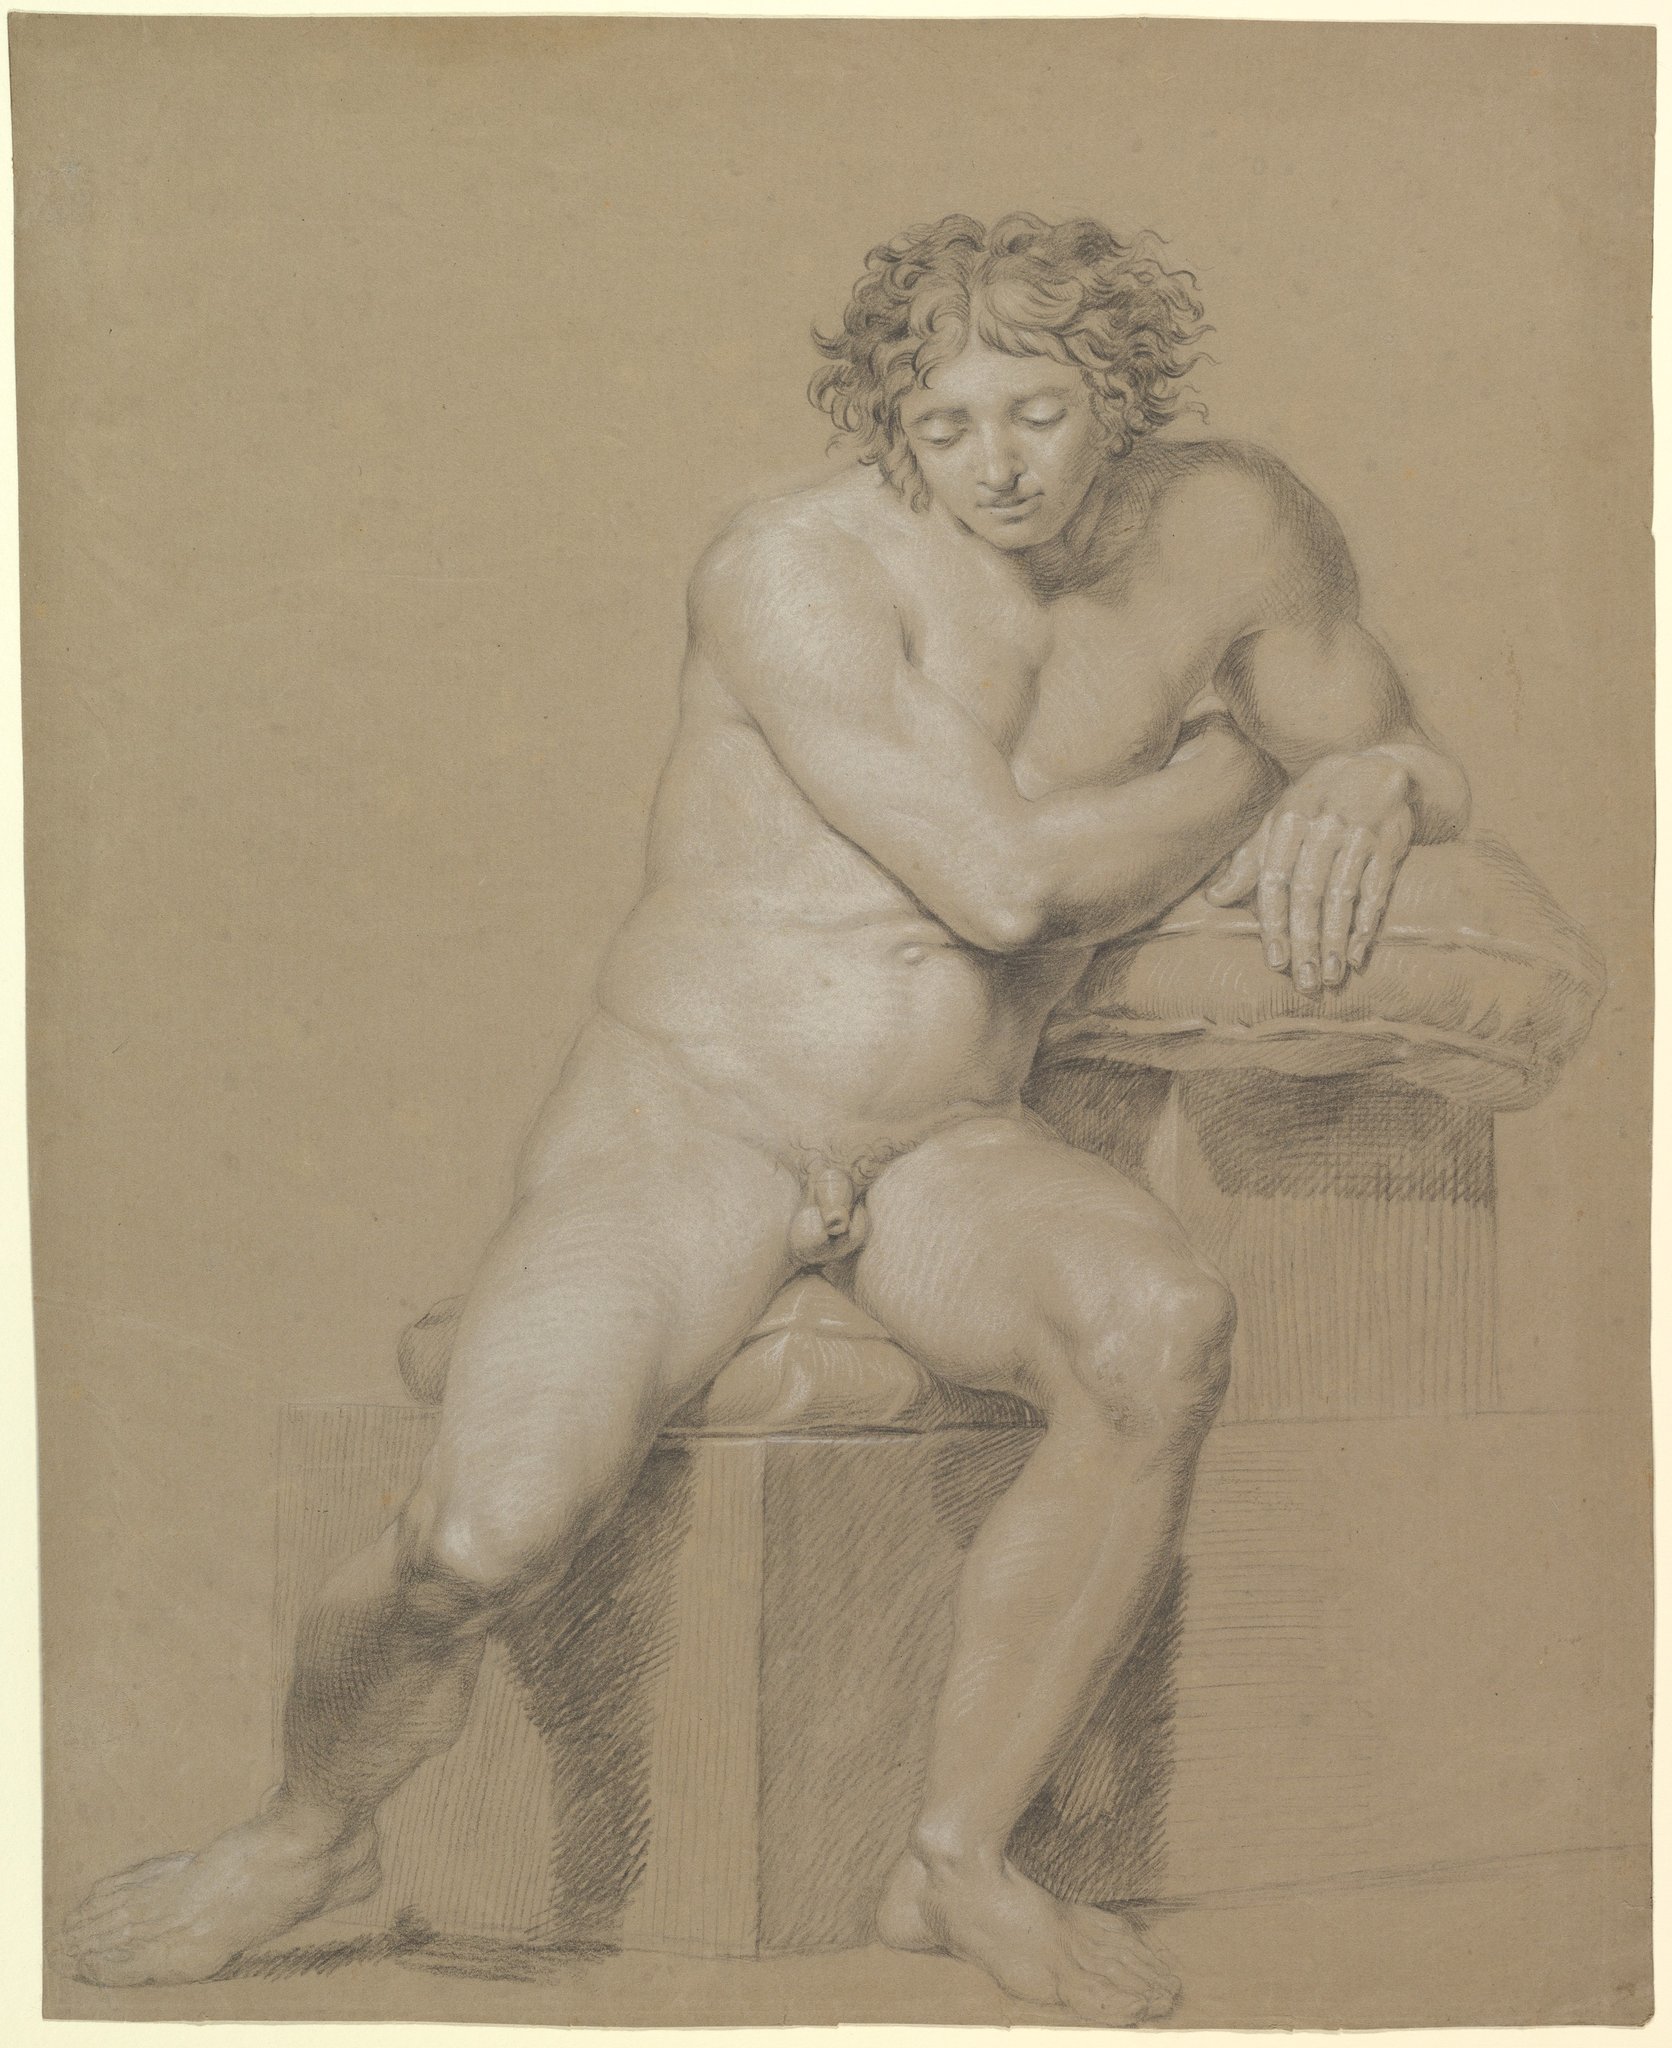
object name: drawing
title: Study of a Seated Male Nude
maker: philipp otto runge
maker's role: artist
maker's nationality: german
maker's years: 1777-1810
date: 1767-1900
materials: chalk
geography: germany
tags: male nudes